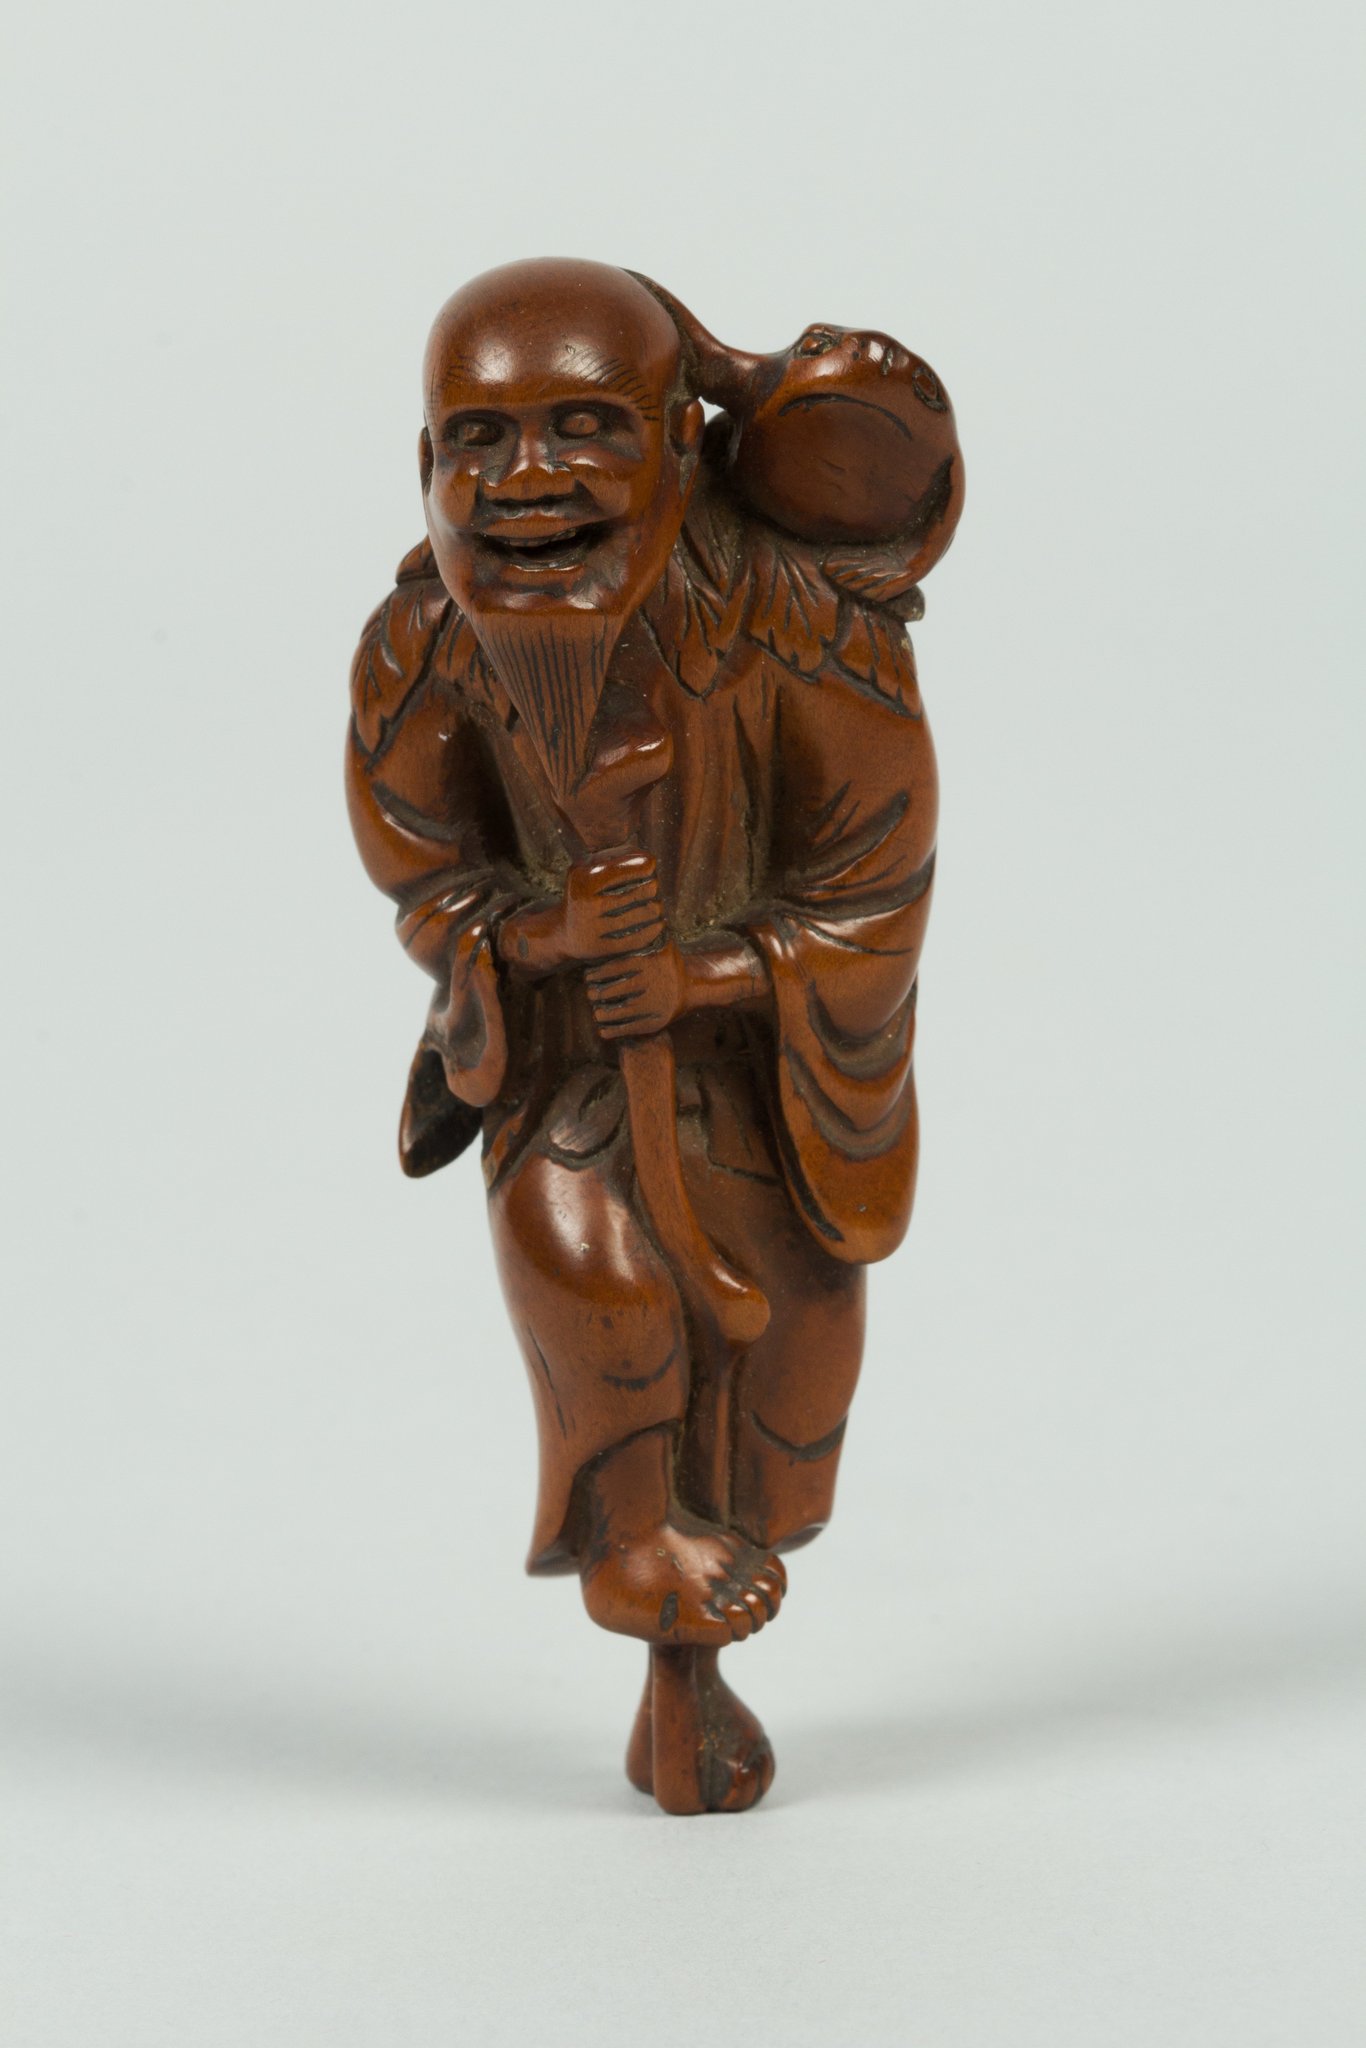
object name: netsuke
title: Netsuke of Old Man Leaning on a Stick; Frog on His Shoulder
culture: japanese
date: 1801-1900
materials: wood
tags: men,frogs